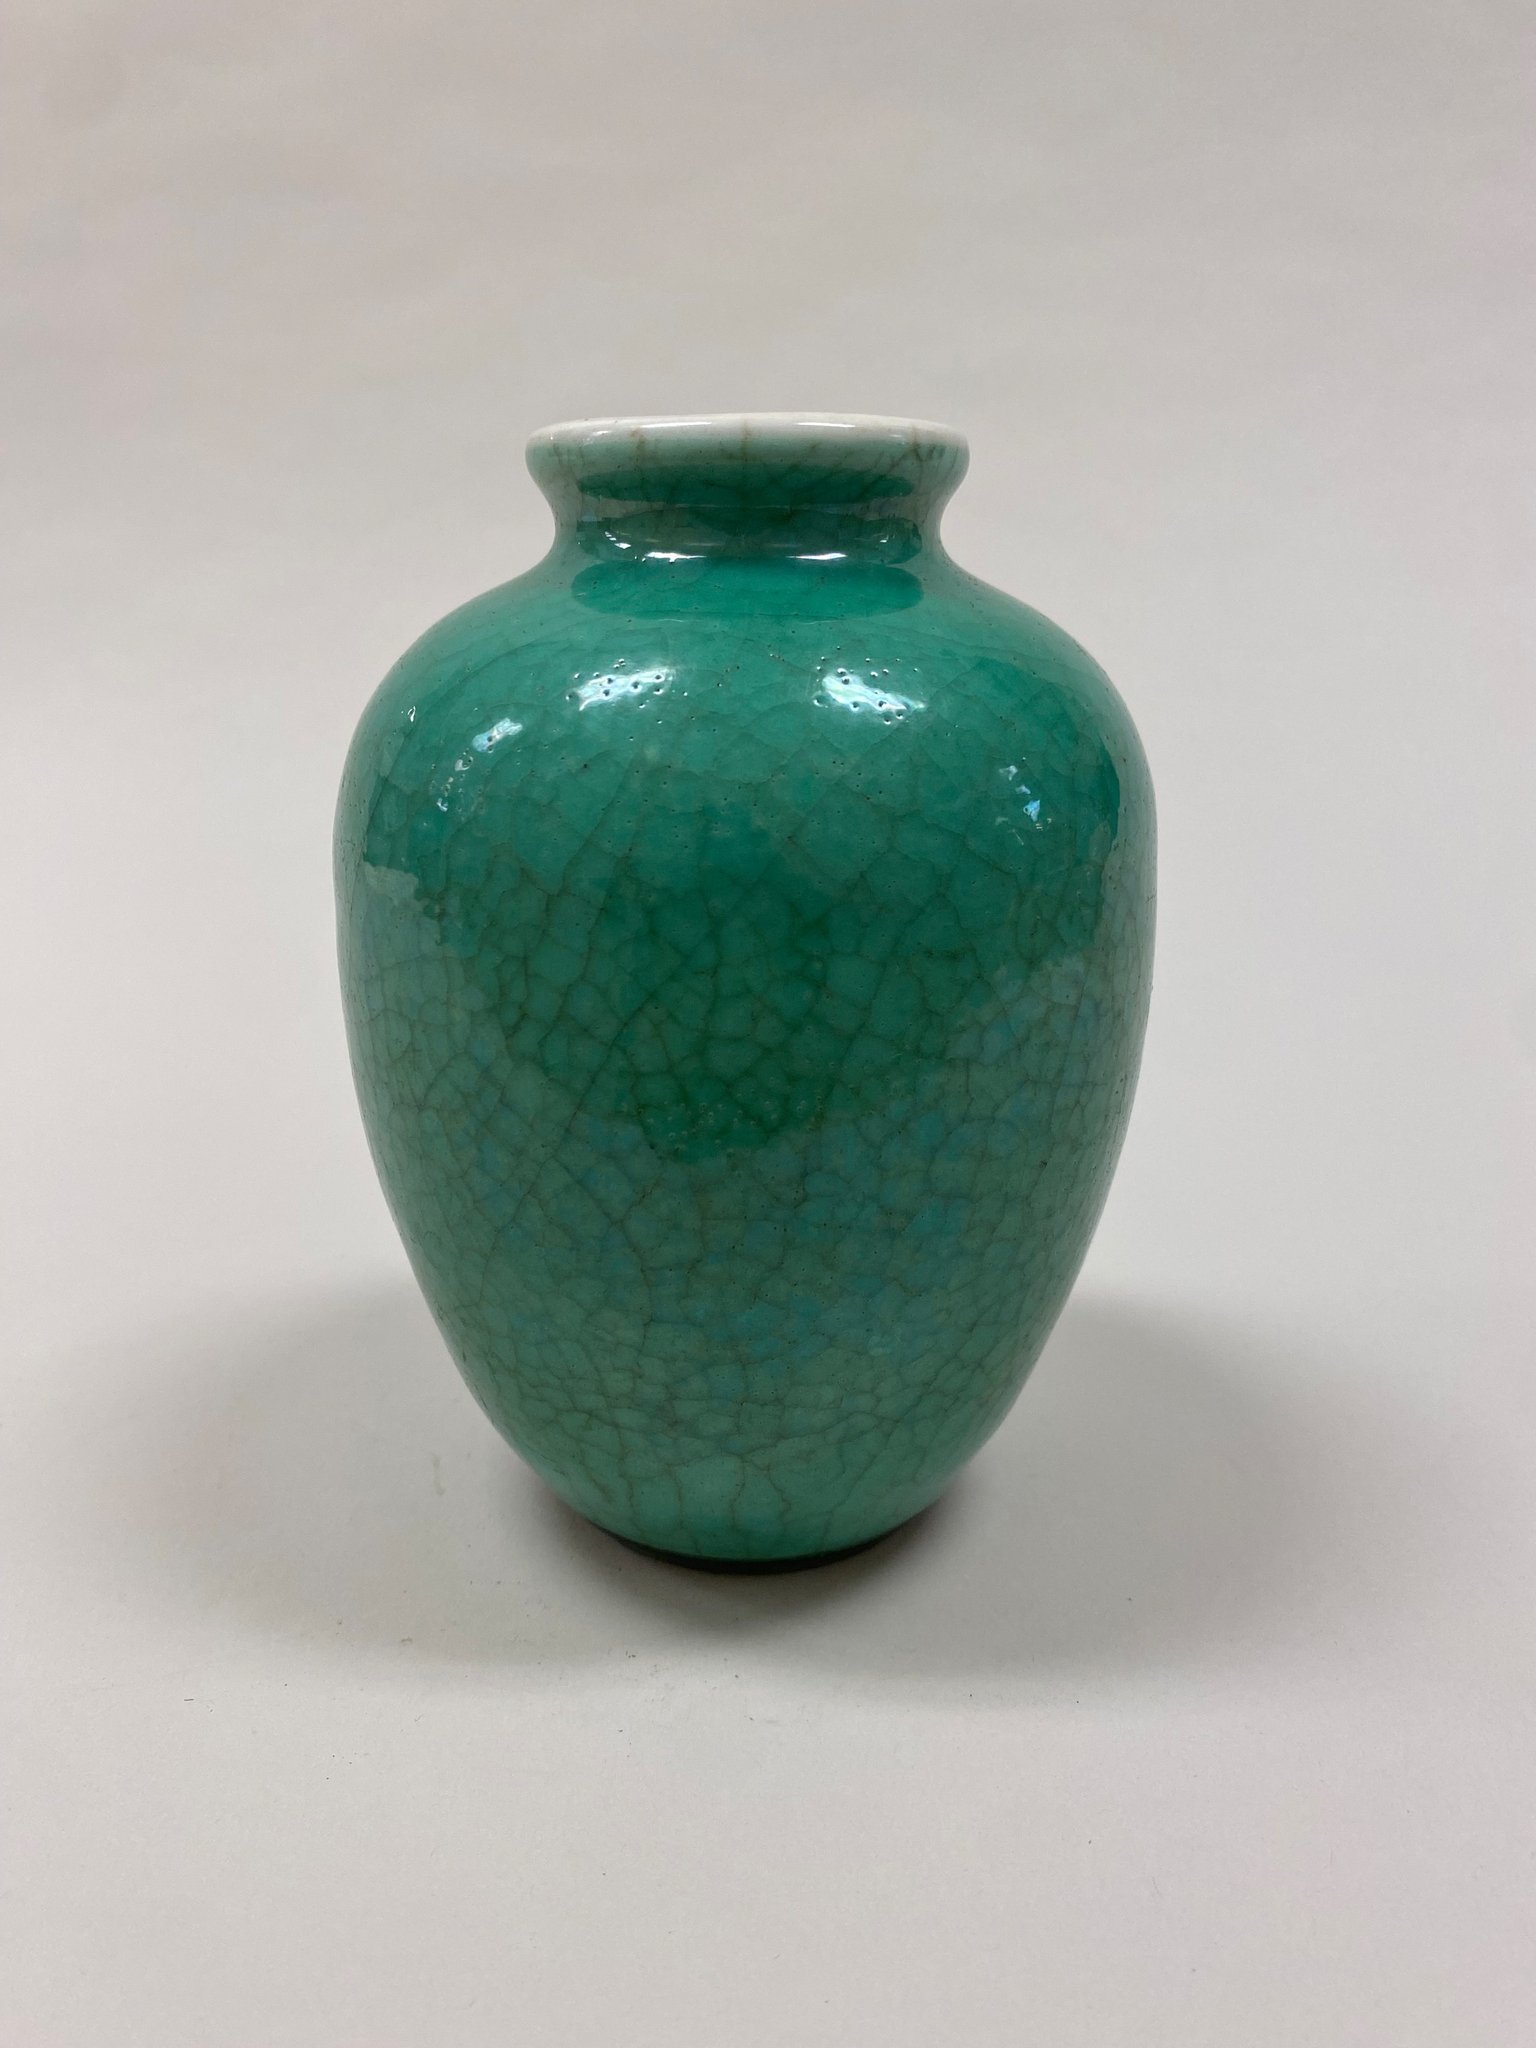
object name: jar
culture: chinese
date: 1701-1733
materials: glaze, porcelain